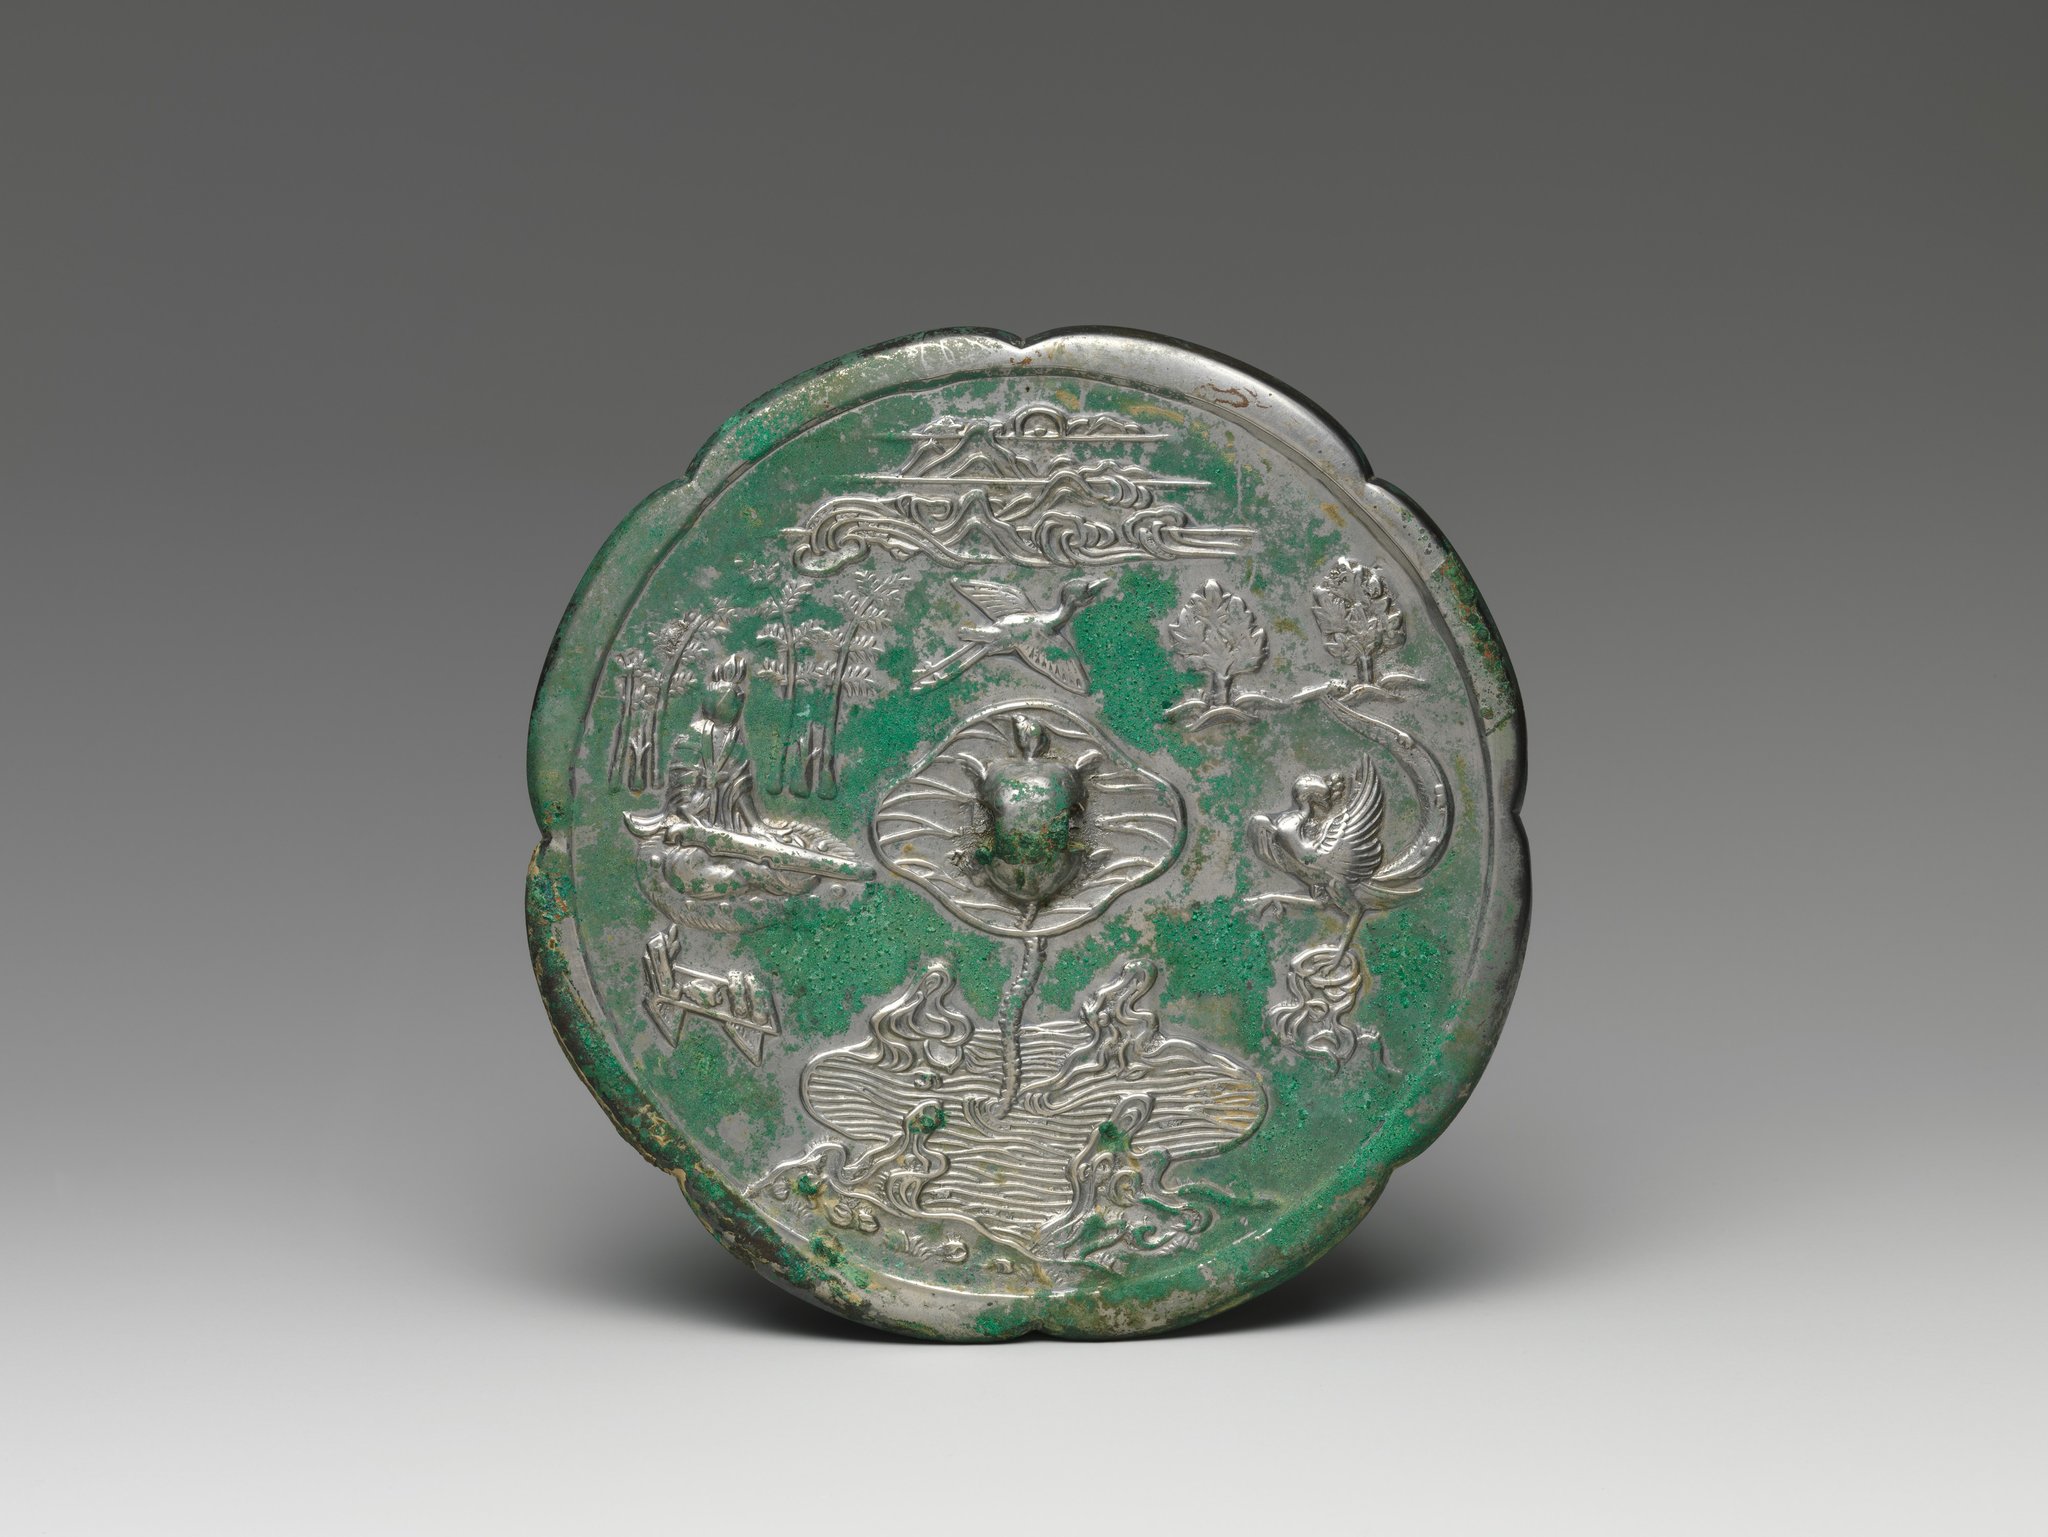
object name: mirror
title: Mirror with immortal and phoenix in a landscape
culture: chinese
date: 767-800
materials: bronze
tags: phoenix,turtles